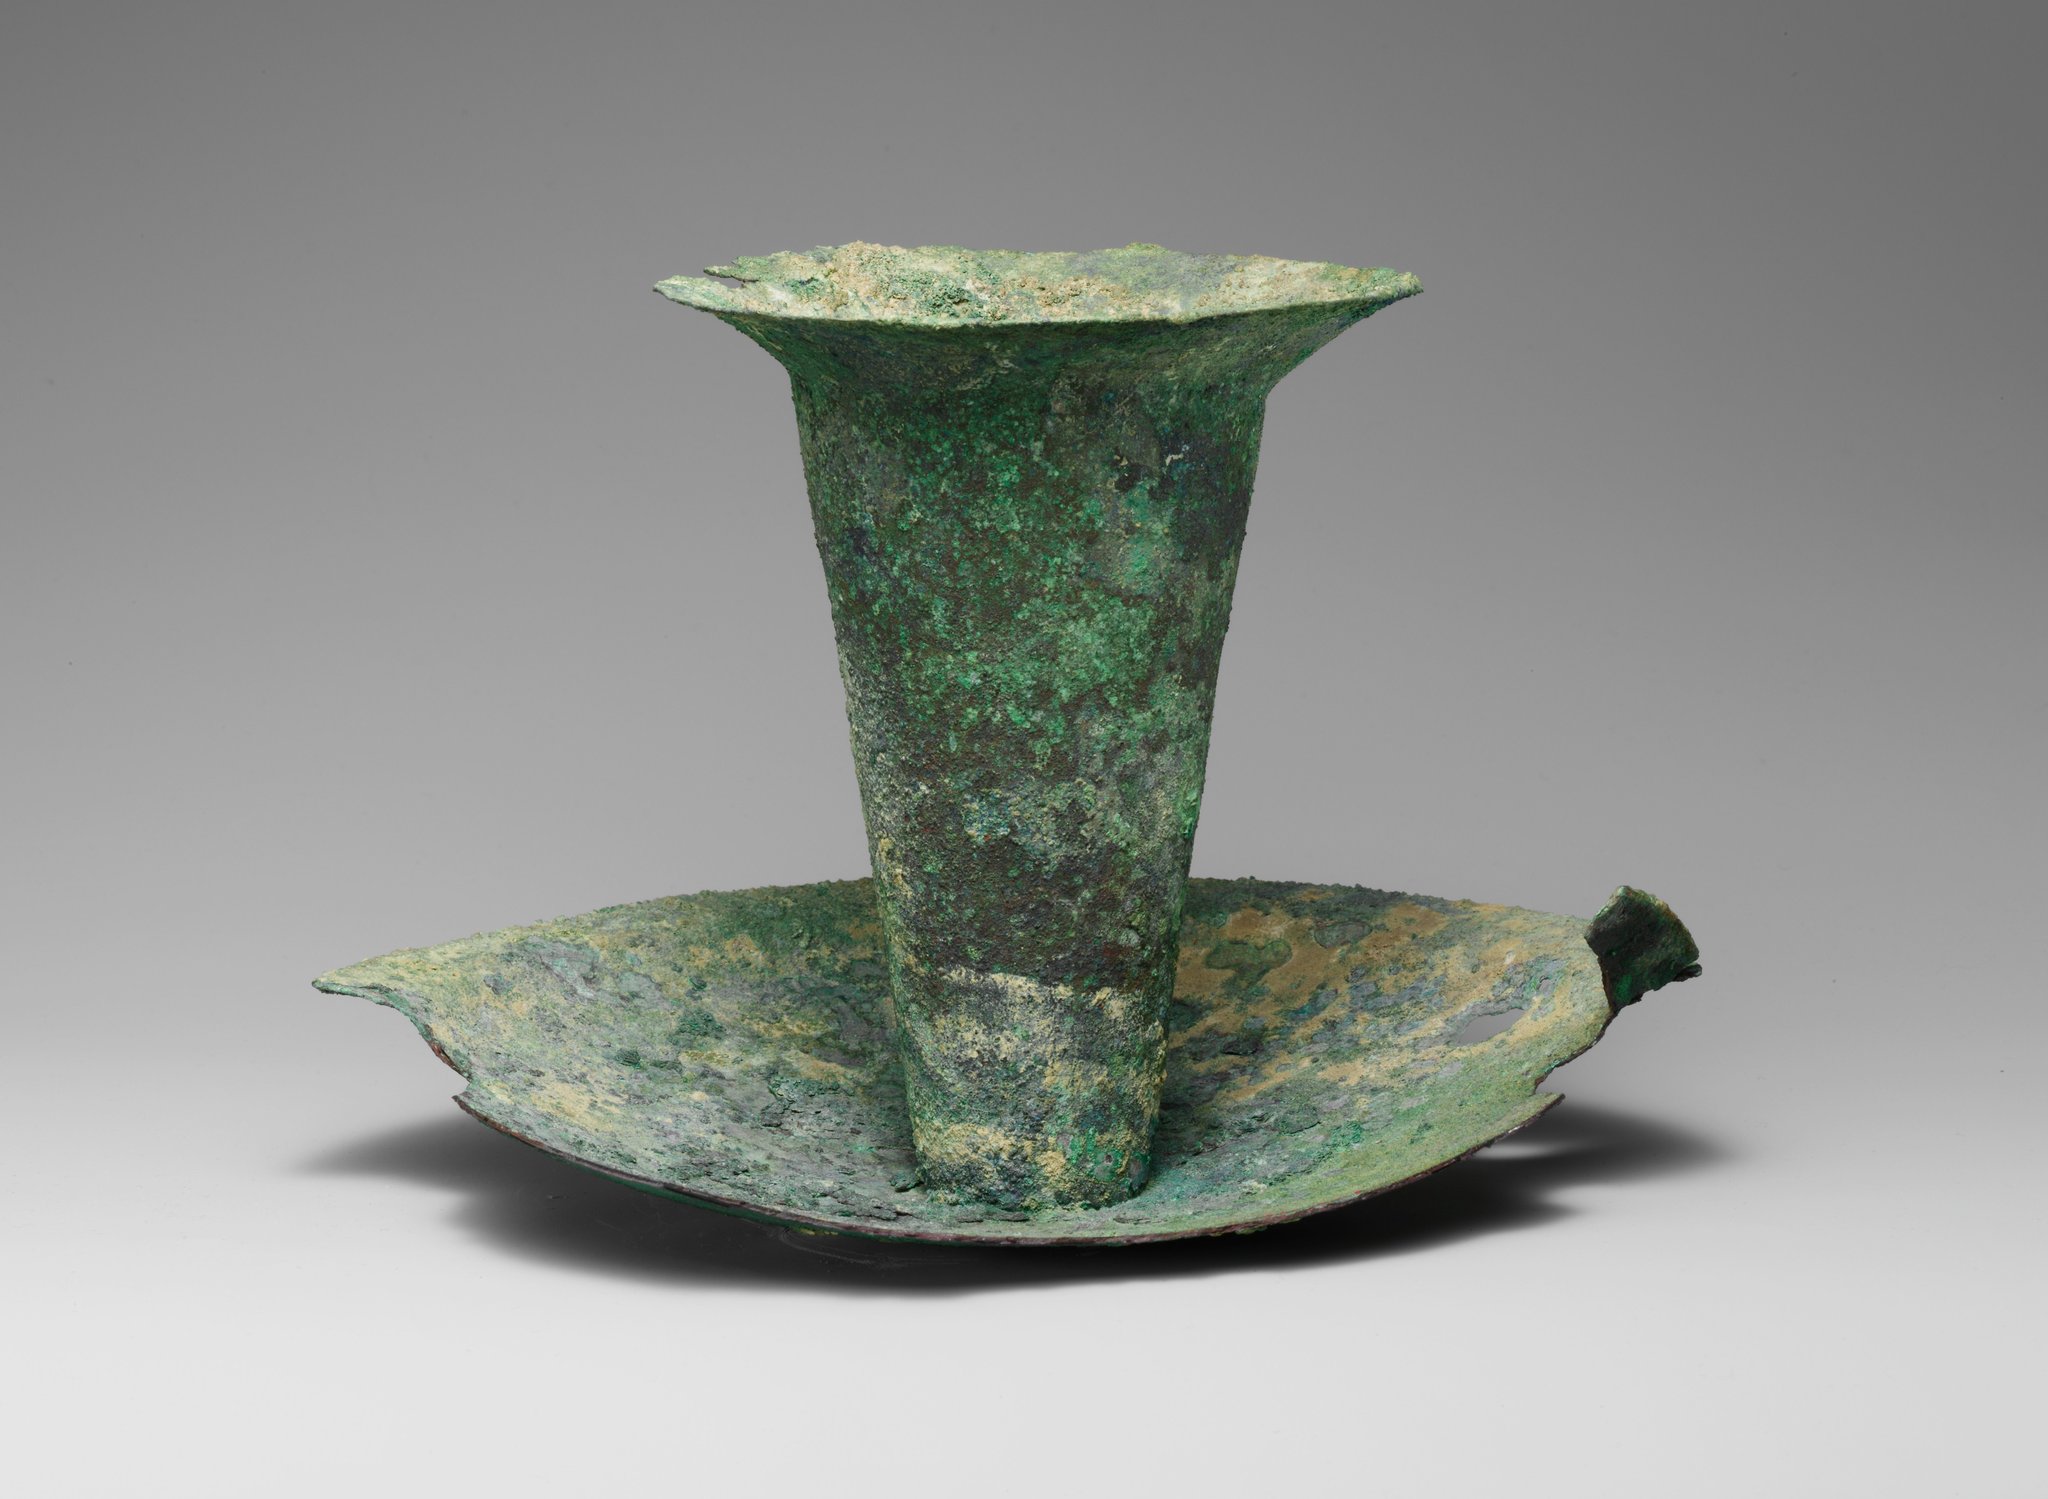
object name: thymiaterion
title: Bronze thymiaterion (incense burner)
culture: cypriot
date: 600-501 BCE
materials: bronze